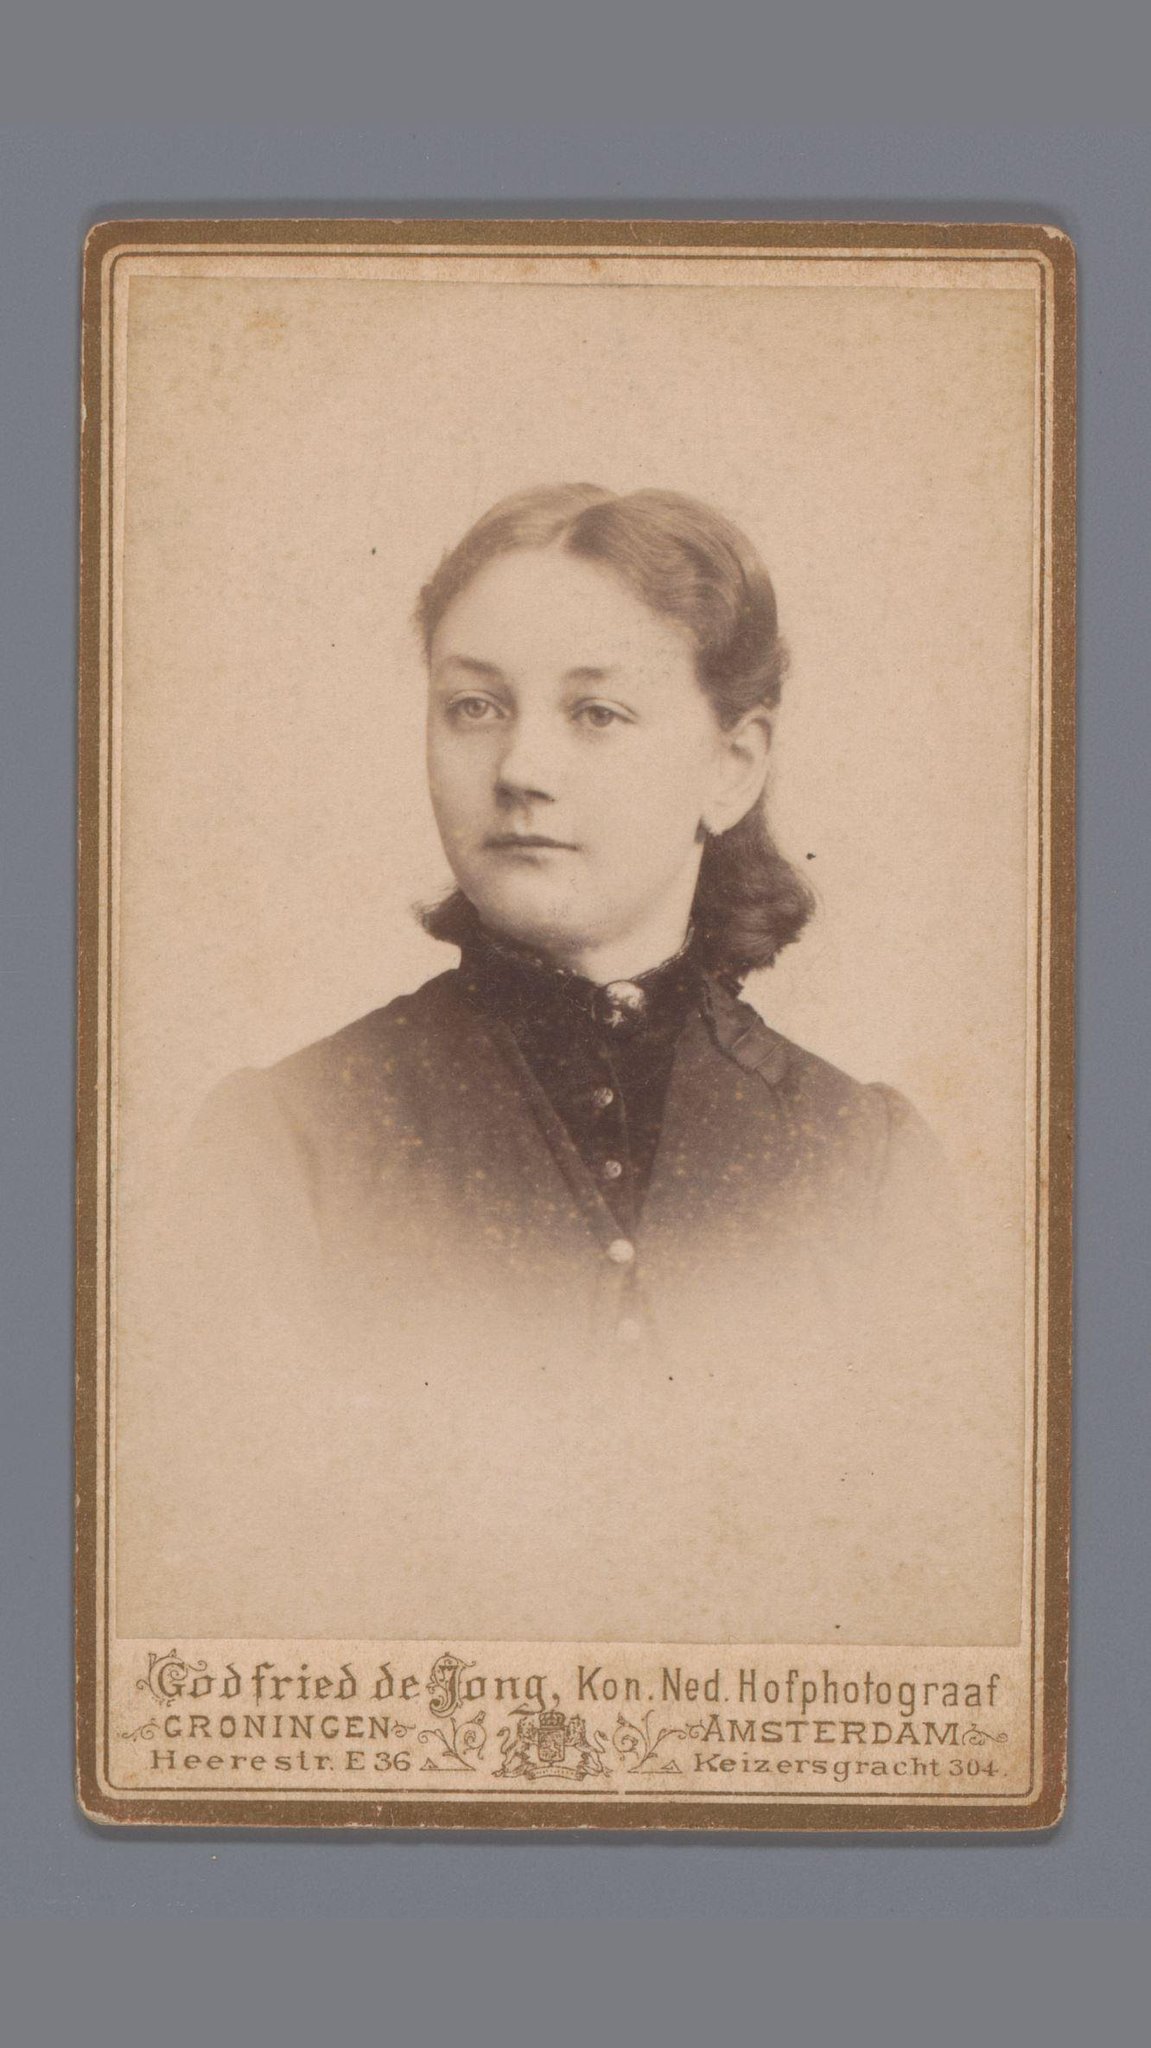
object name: carte de visite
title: Portret van een onbekende vrouw, aangeduid als Jo de Vries of mevrouw Grommers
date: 1887-1896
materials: cardboard, paper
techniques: albumen print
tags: historical persons - bb - woman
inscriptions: address: ‘Godried de Jong, Kon. Ned. Hofphotograaf/ GRONINGEN/ Heerestr. E 36/ AMSTERDAM/ Keizersgracht 304.’, stamp: ‘W. B. BEKROONDE/ Photograaf [...]/ Heerestraat E. 36/ GRONINGEN.’, inscription: ‘Jo de Vries/ Mevr Grommers’, inscription: ‘Bekroond op de/ Internationale Tentoonstelling/ te AMSTERDAM 1874 en 1883./ Godfried de Jong/ Photographe-Artiste/ VAN Z.M./ den Koning/ der/ Nederlanden./ en geoctroijeerd/ door/ Z.M. den Koning der Belgen./ Groningen/ en/ Amsterdam./ Van deze photographie kan nabesteld worden/ Vergrooting naar visitekaarten in alle afmetingen.’